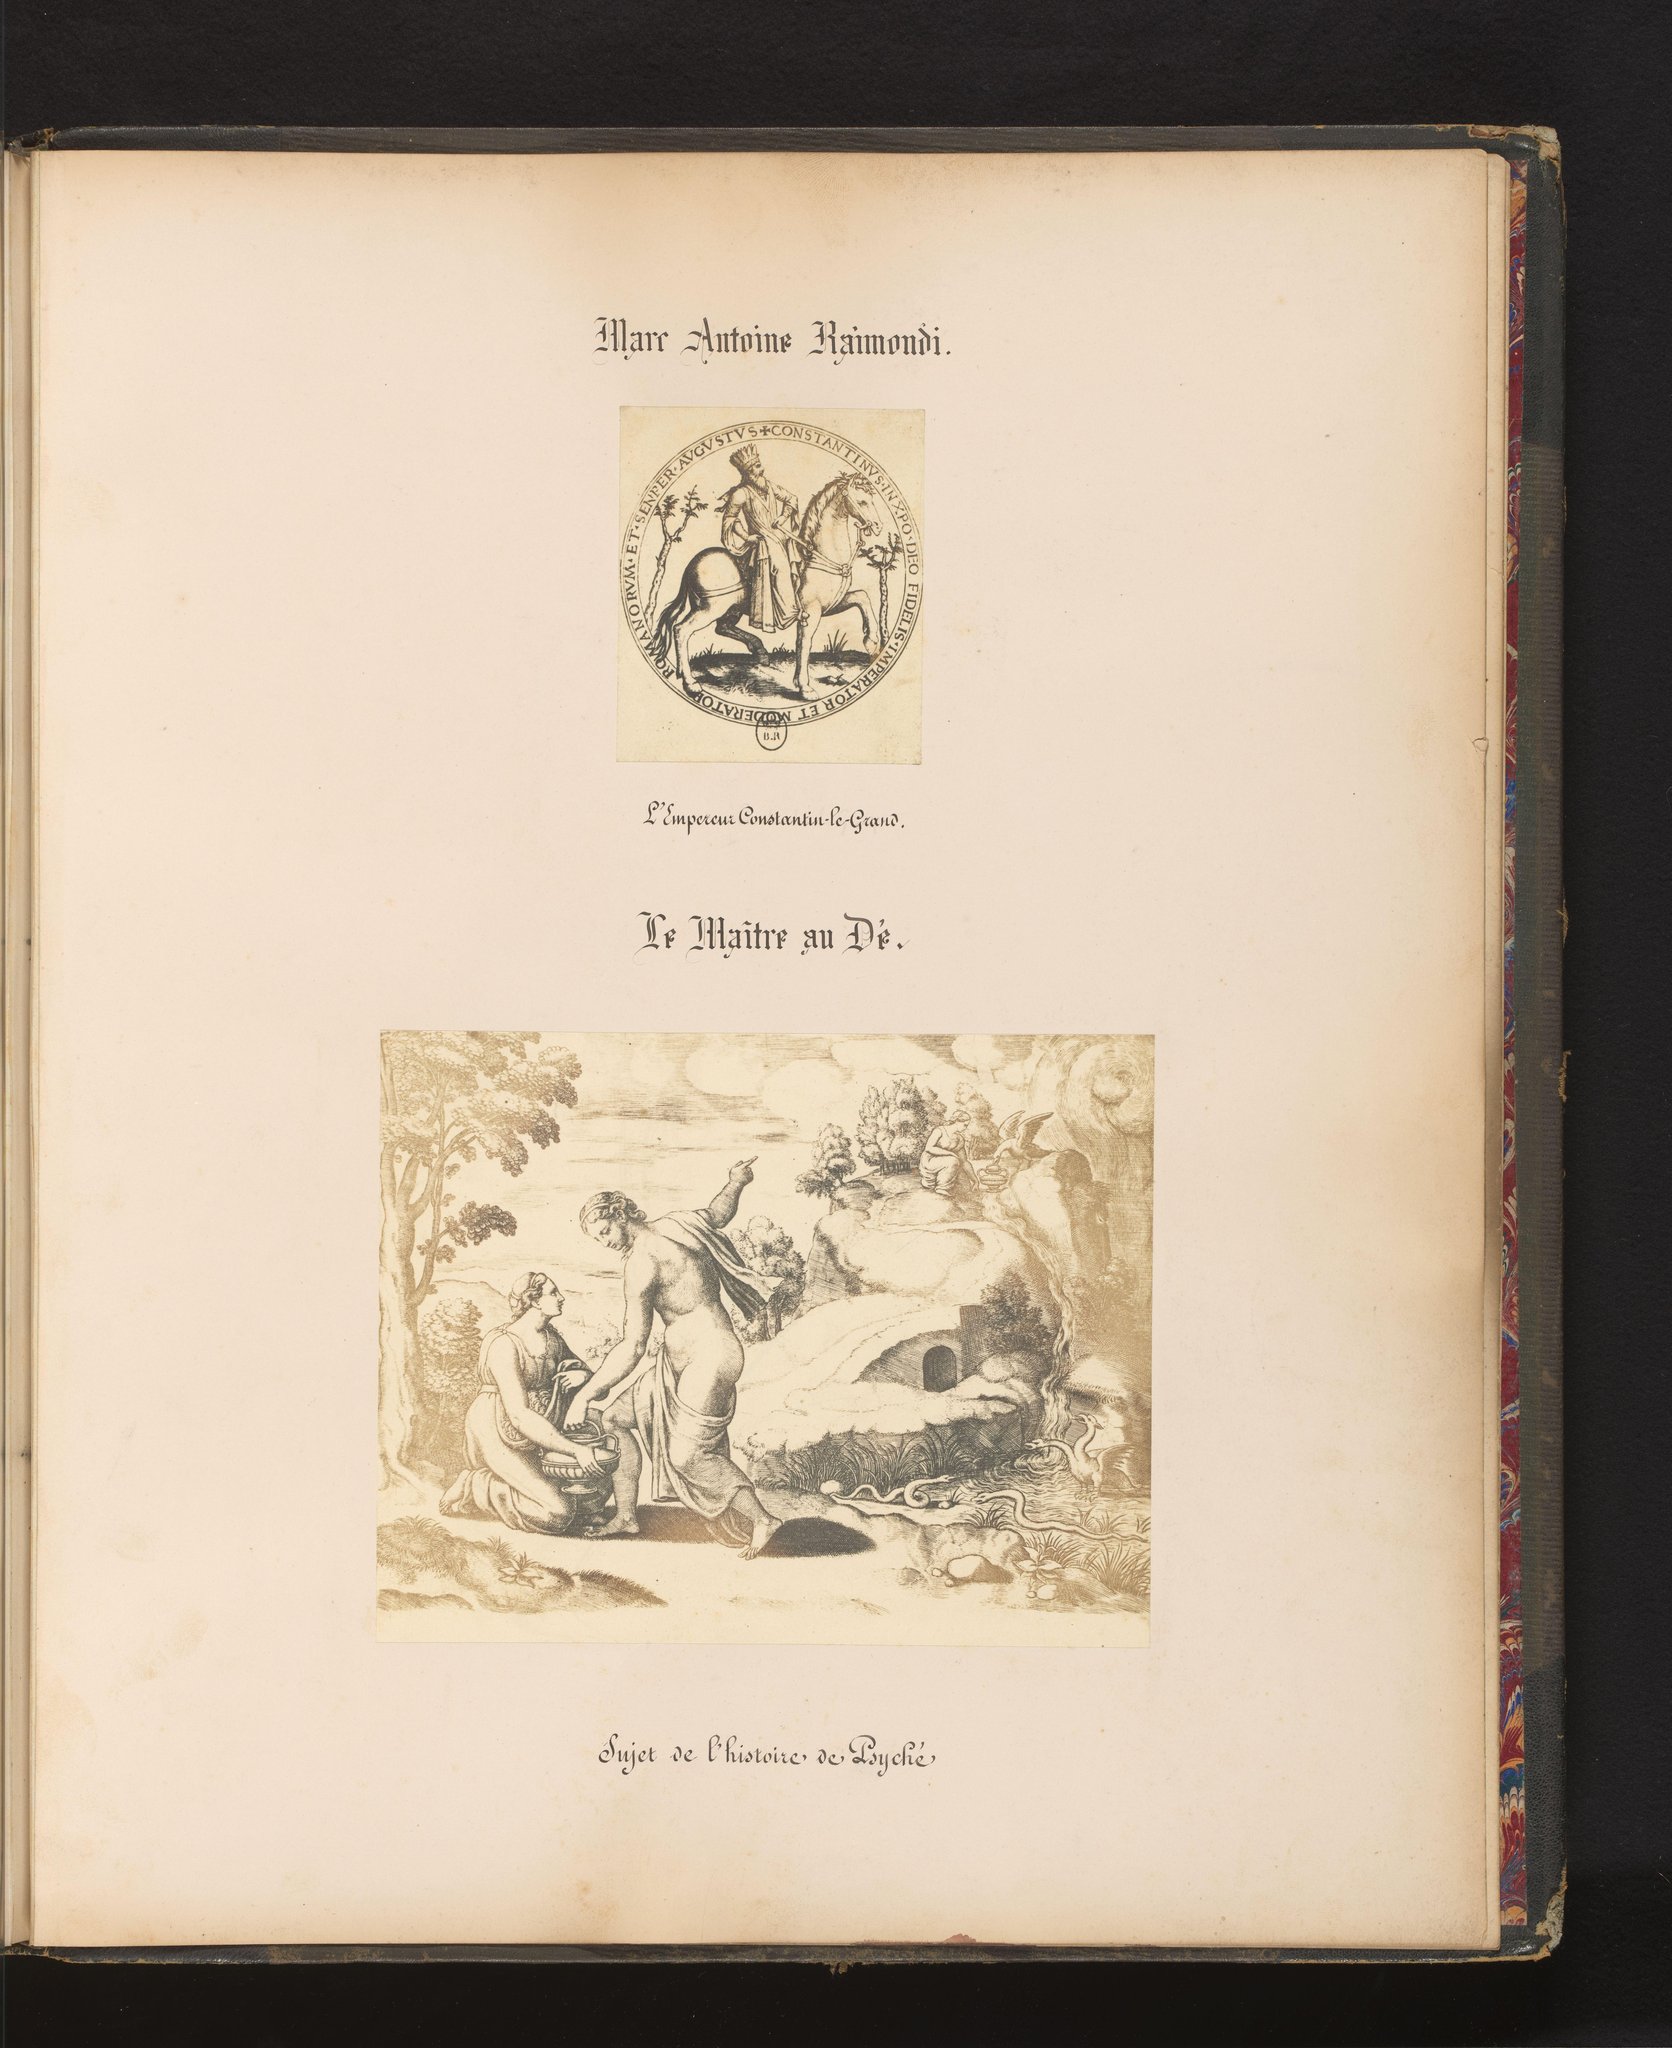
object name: page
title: Fotoreproductie van een gravure van Constantijn de Grote door Marcantonio Raimondi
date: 1848-1853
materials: photographic support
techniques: salted paper print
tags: the roman emperor constantine the great; possible attributes: crown, sceptre, standard (labarum) with chi-rho monogram or cross